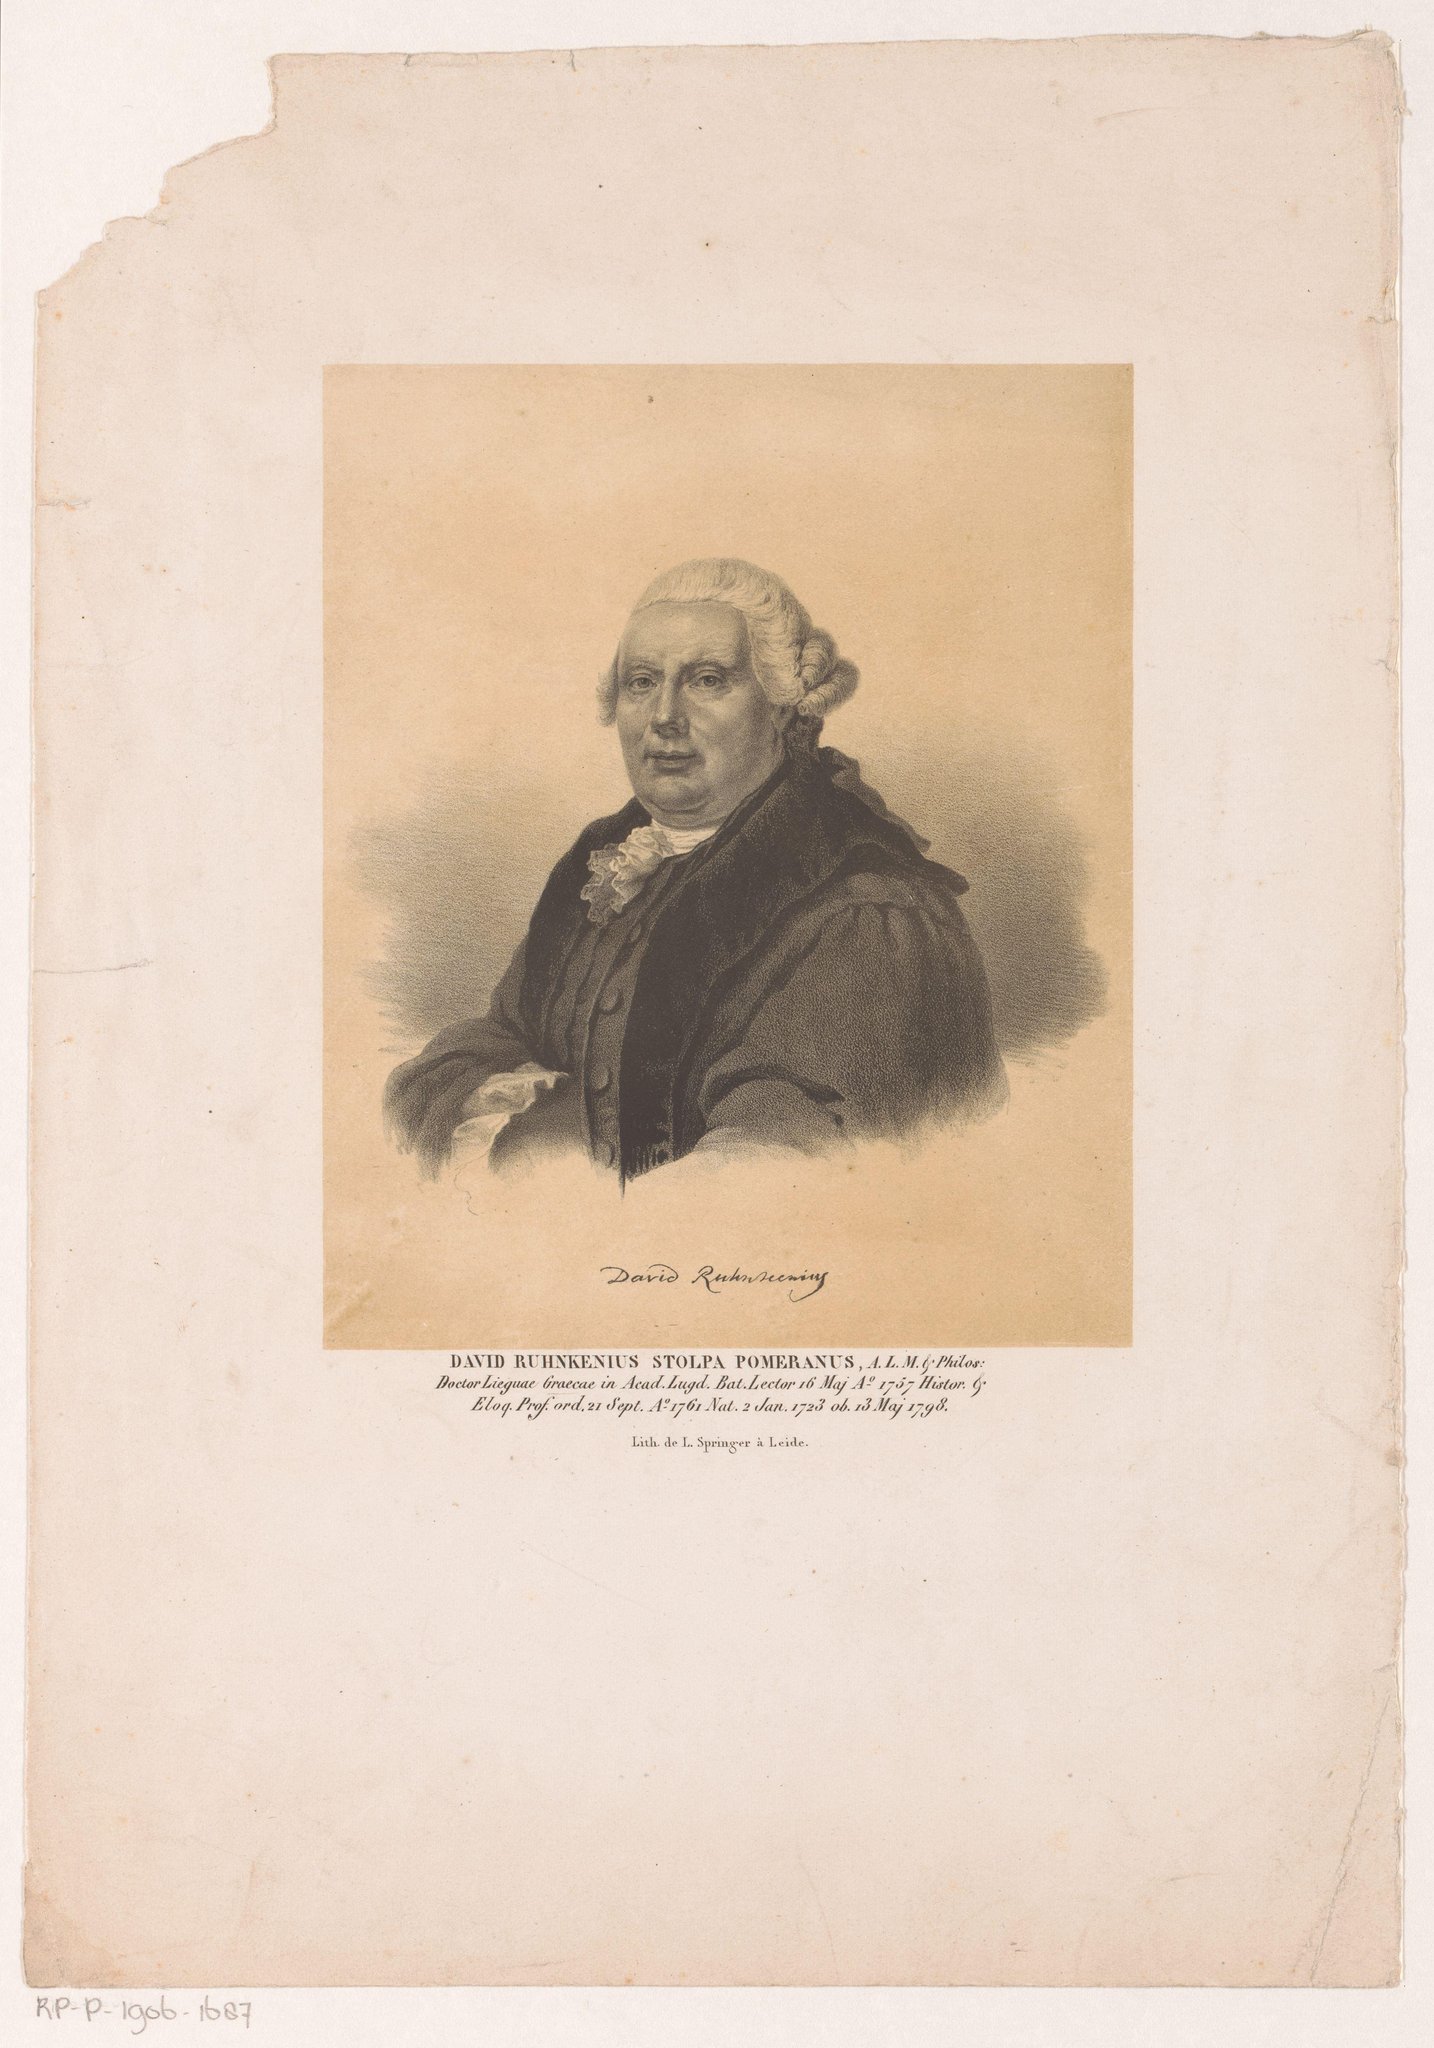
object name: print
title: David Ruhnkenius Stolpa Pomeranus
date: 1809-1853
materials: paper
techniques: tone lithography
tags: leiden, historical persons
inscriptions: collector's mark: Lugt 2228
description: Onder het portret de signatuur en biografische gegevens van de geportretteerde.